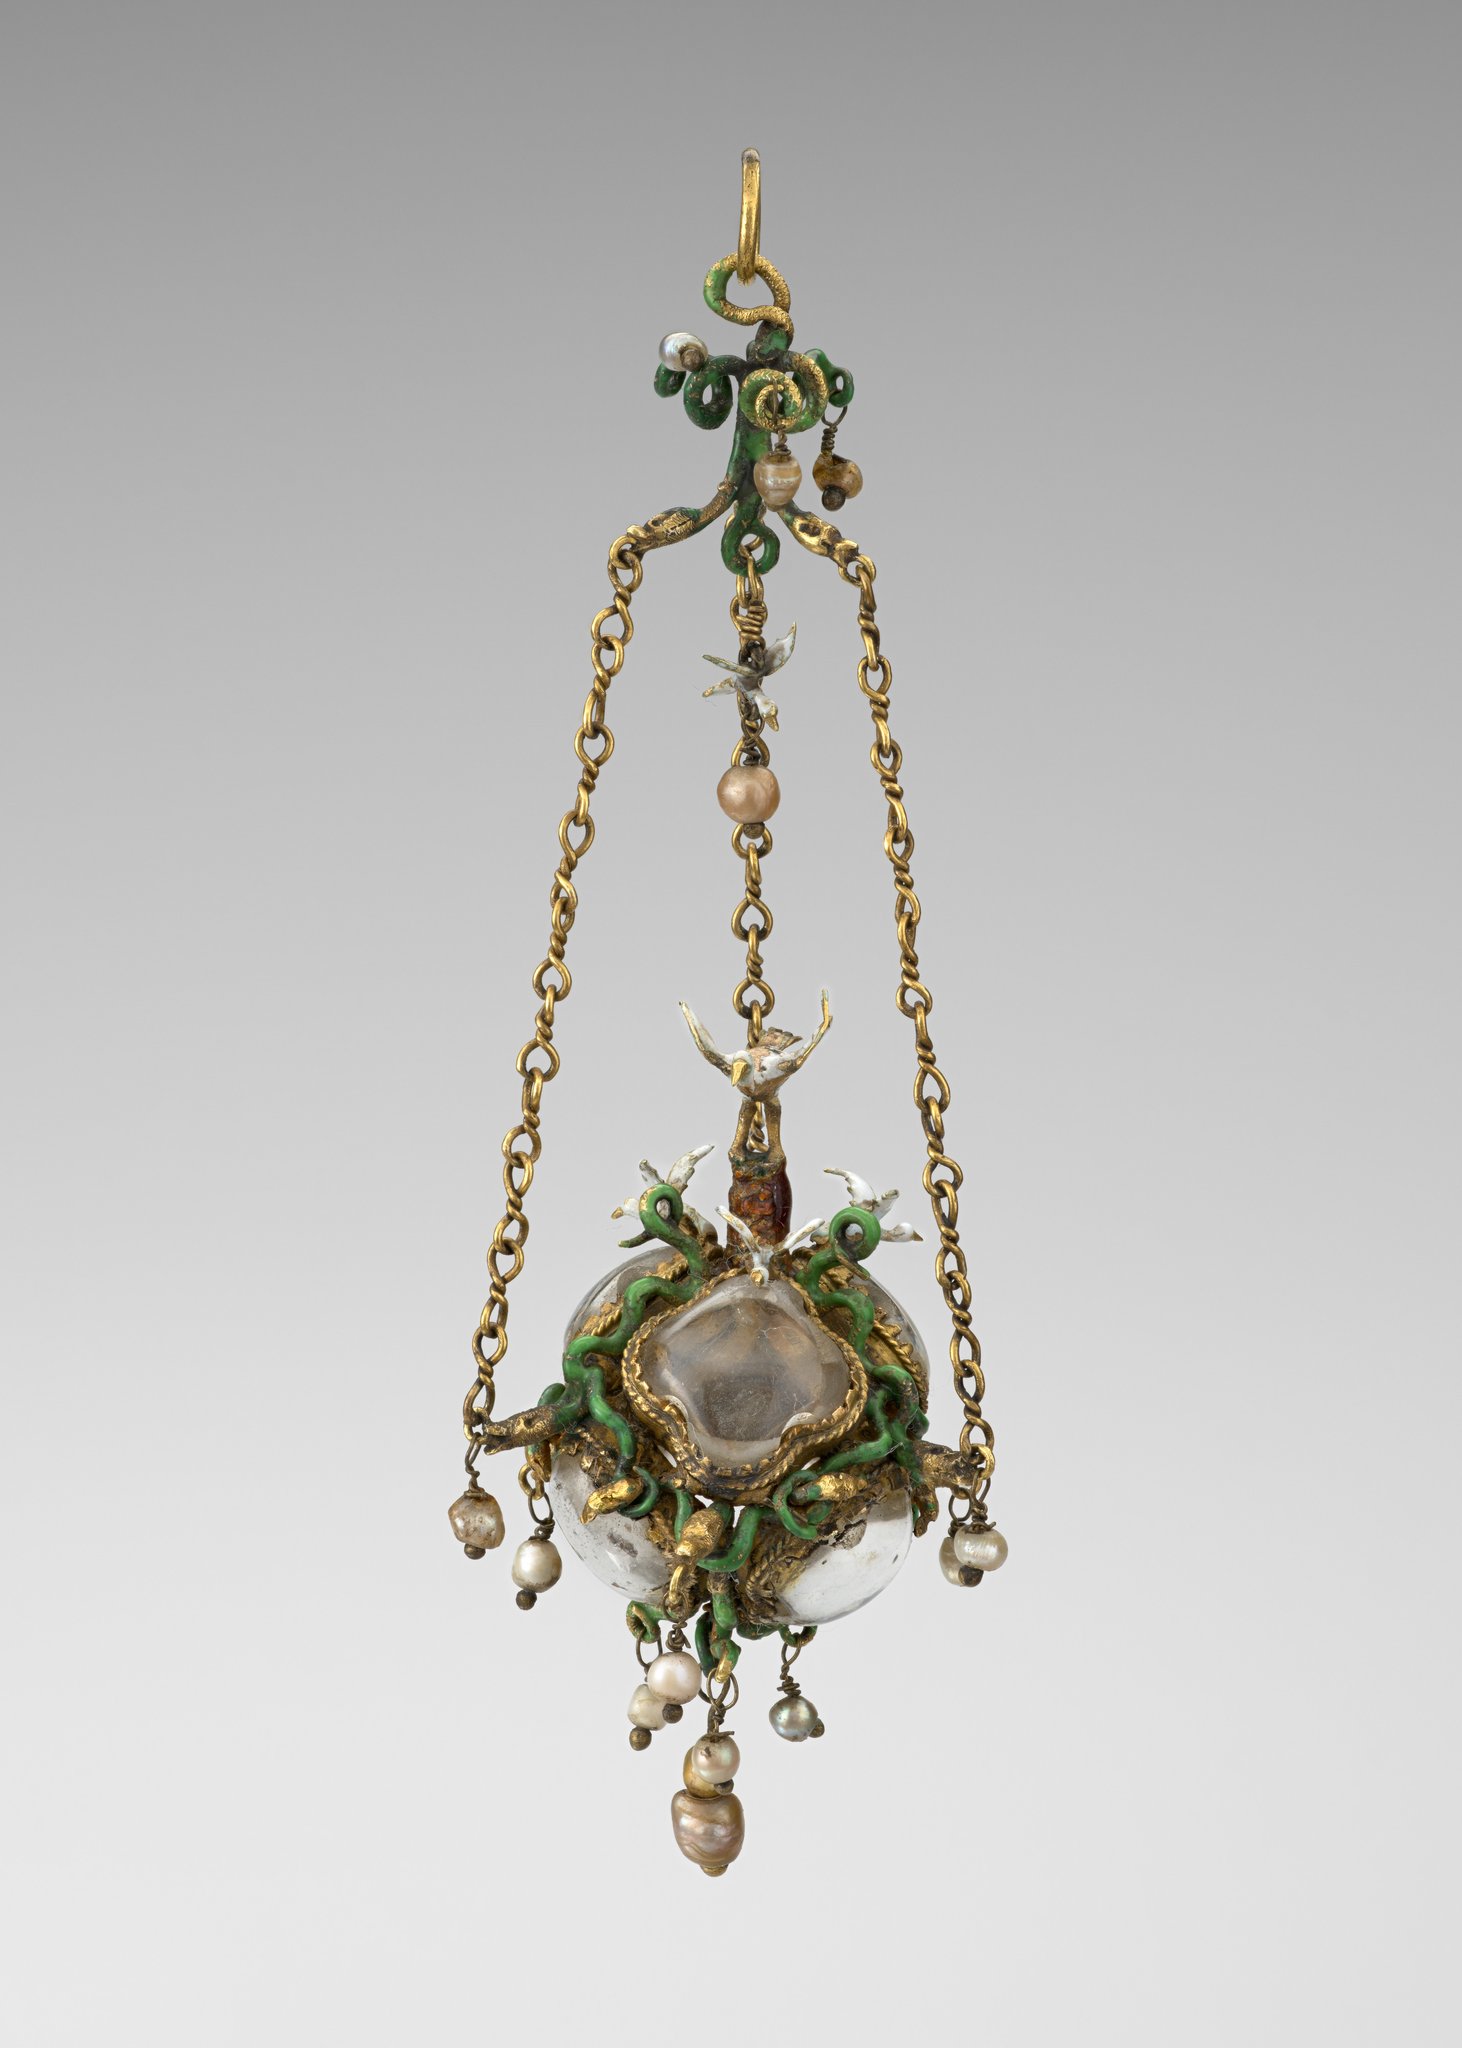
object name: pendant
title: Sixteenth-century-style pendant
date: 1801-1900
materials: crystal, enamel, gold, pearl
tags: birds